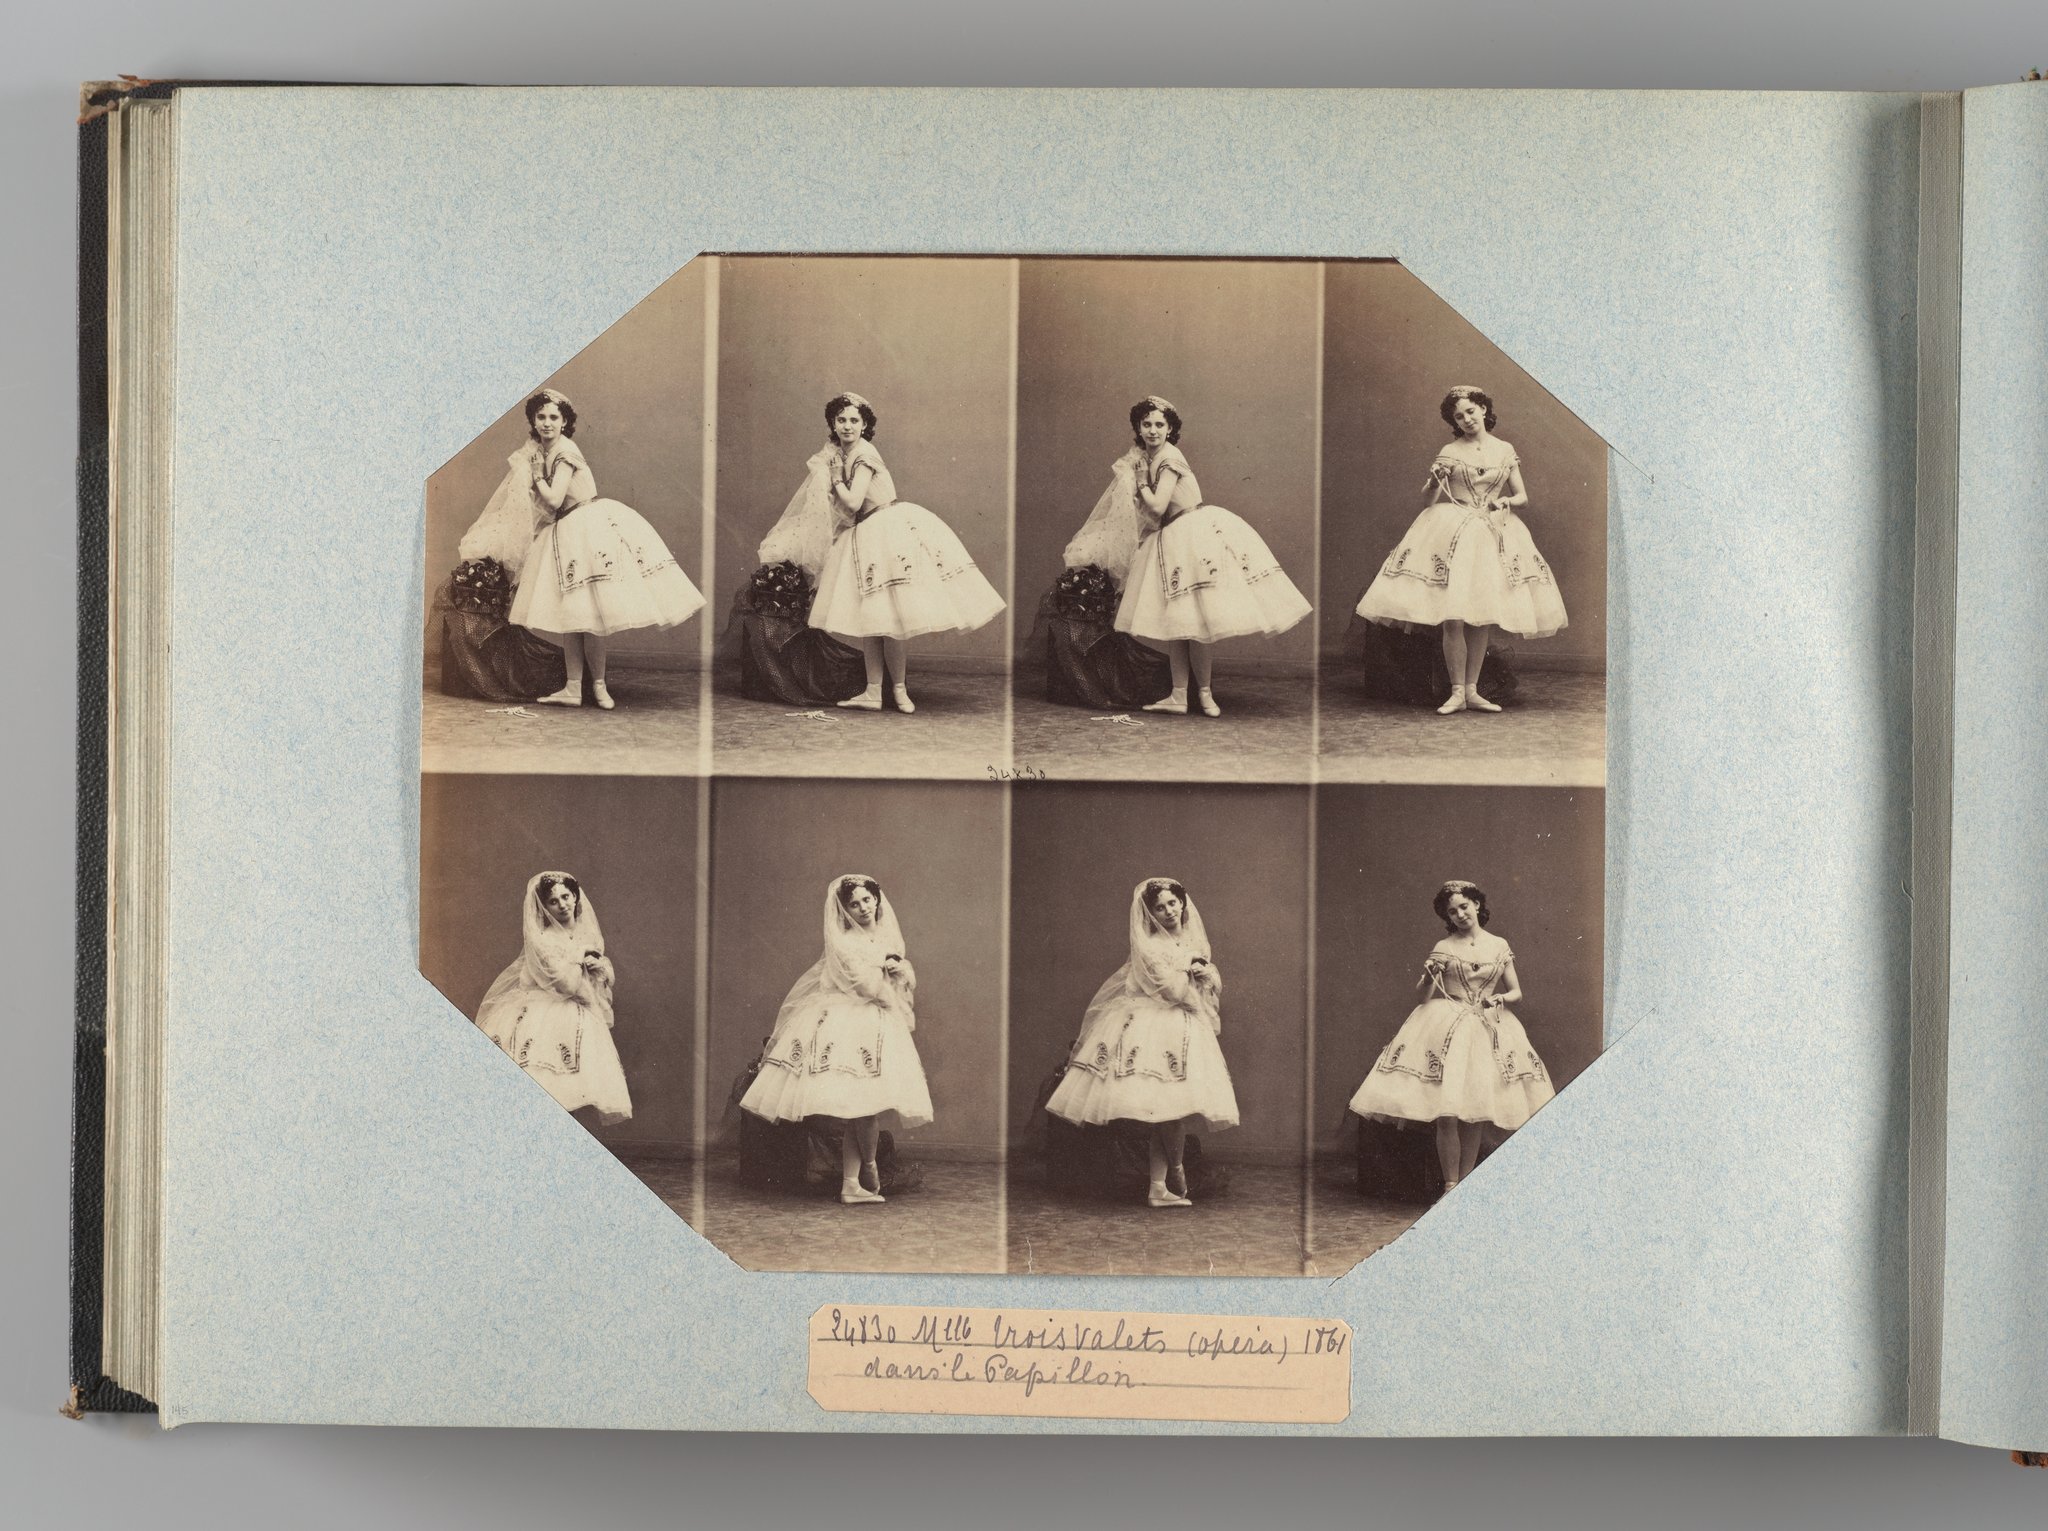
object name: photograph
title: Mlle Troisvalets dans le Papillon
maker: andré-adolphe-eugène disdéri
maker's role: artist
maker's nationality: french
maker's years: 1819-1889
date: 1861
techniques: albumen silver print, glass negative